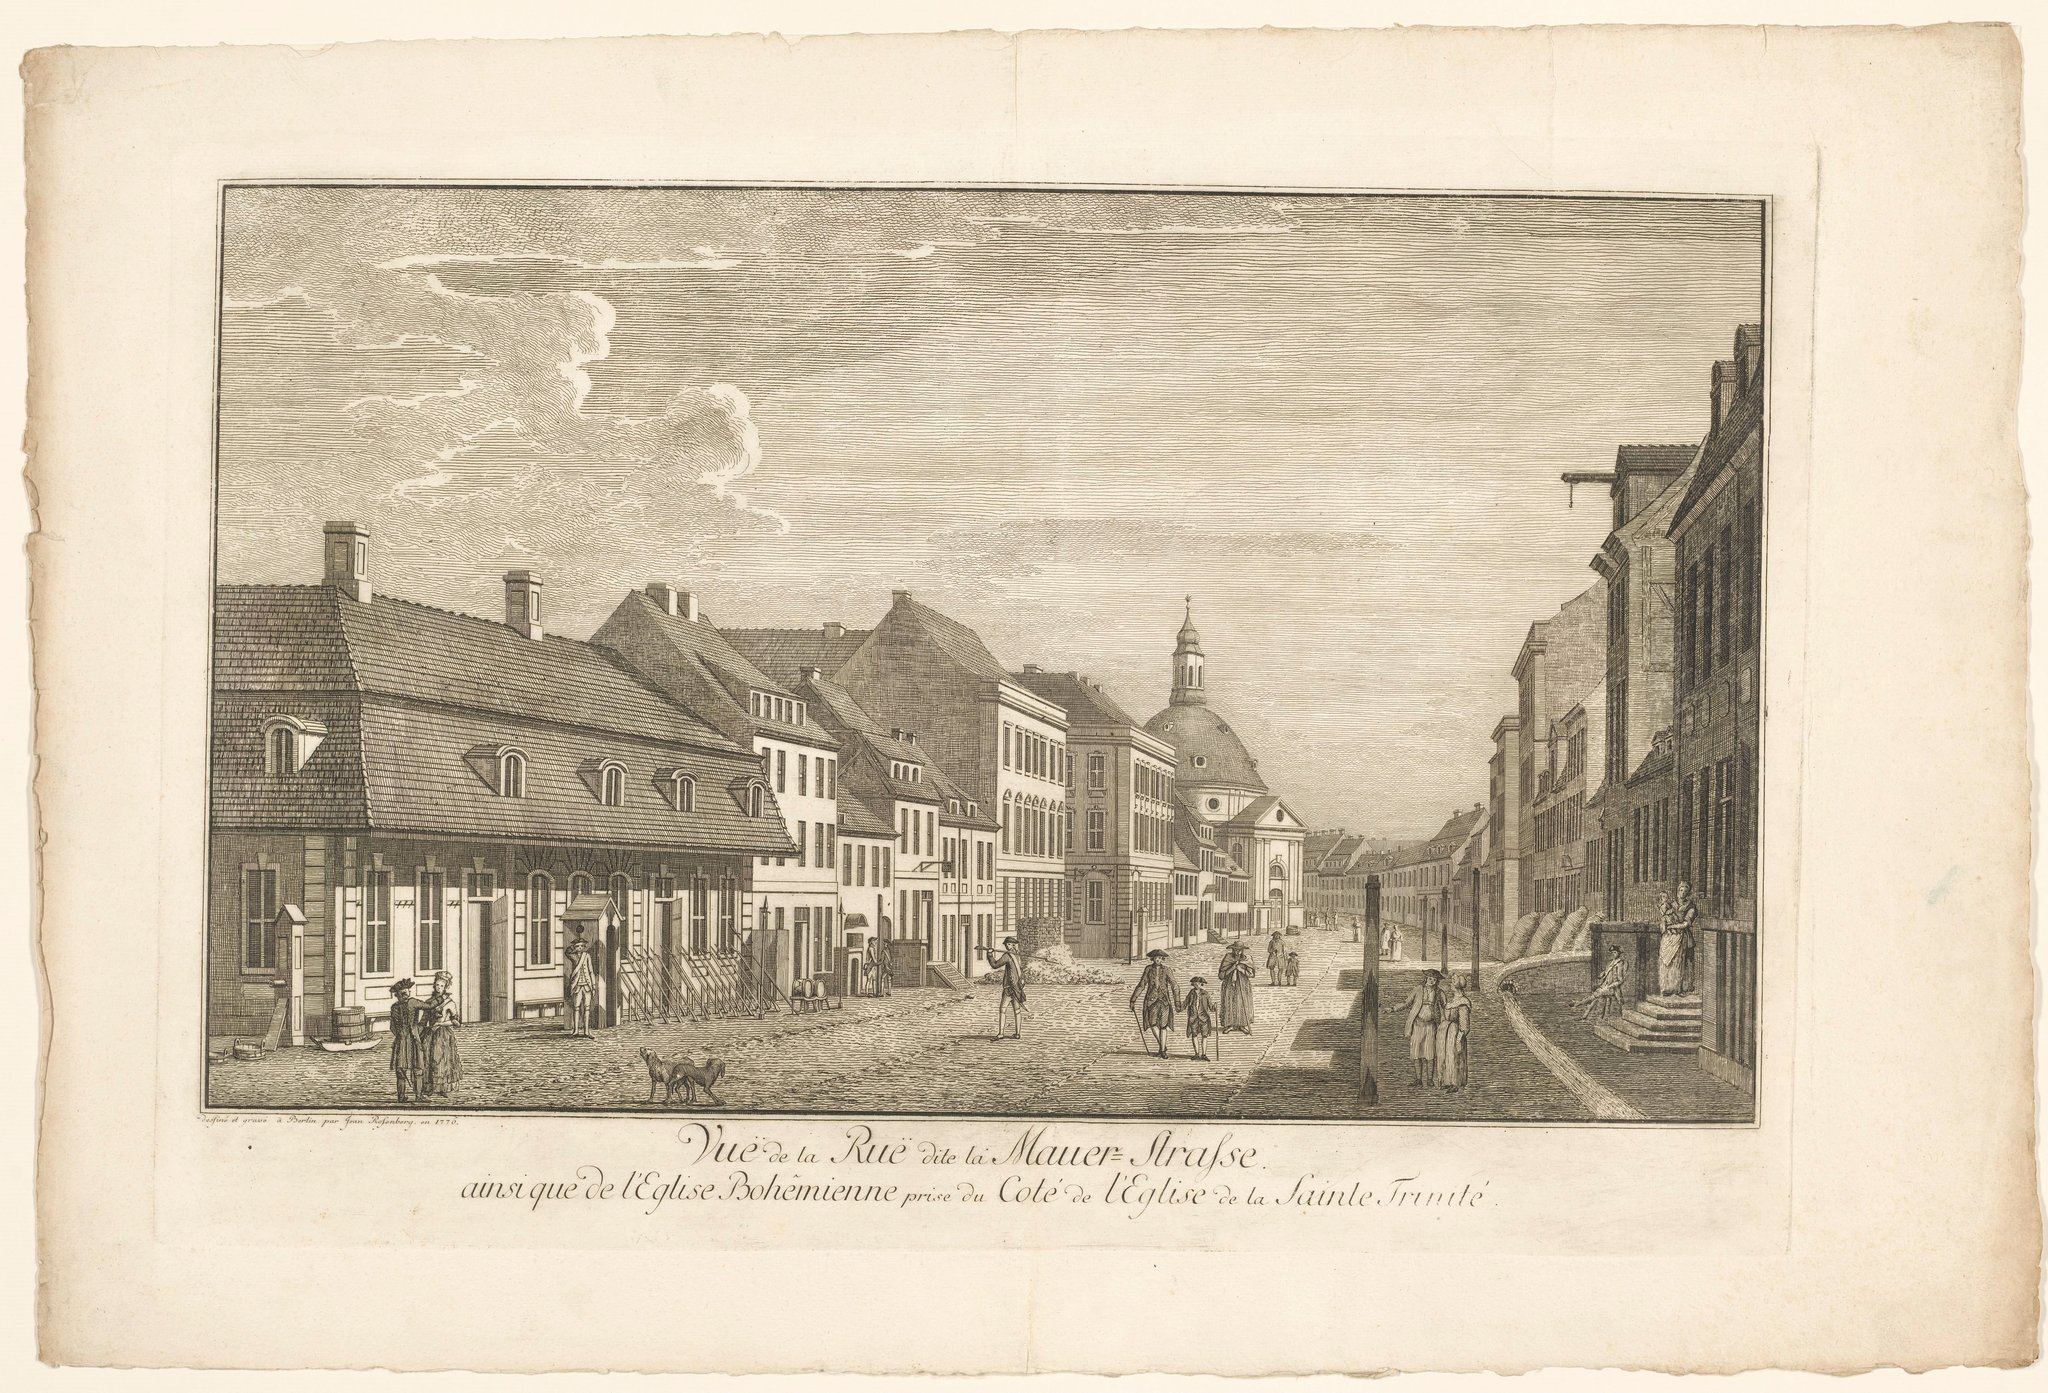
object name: print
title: Vuë de la ruë dite la Mauer-Strasse ainsi que l'Eglise Bohêmienne prise du côté de l'Eglise de la Sainte Trinité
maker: johann georg rosenberg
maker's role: print maker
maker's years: 1739-1808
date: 1776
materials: paper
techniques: etching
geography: germany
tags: city-view in general; 'veduta', church (exterior)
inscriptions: collector's mark: Lugt 2228